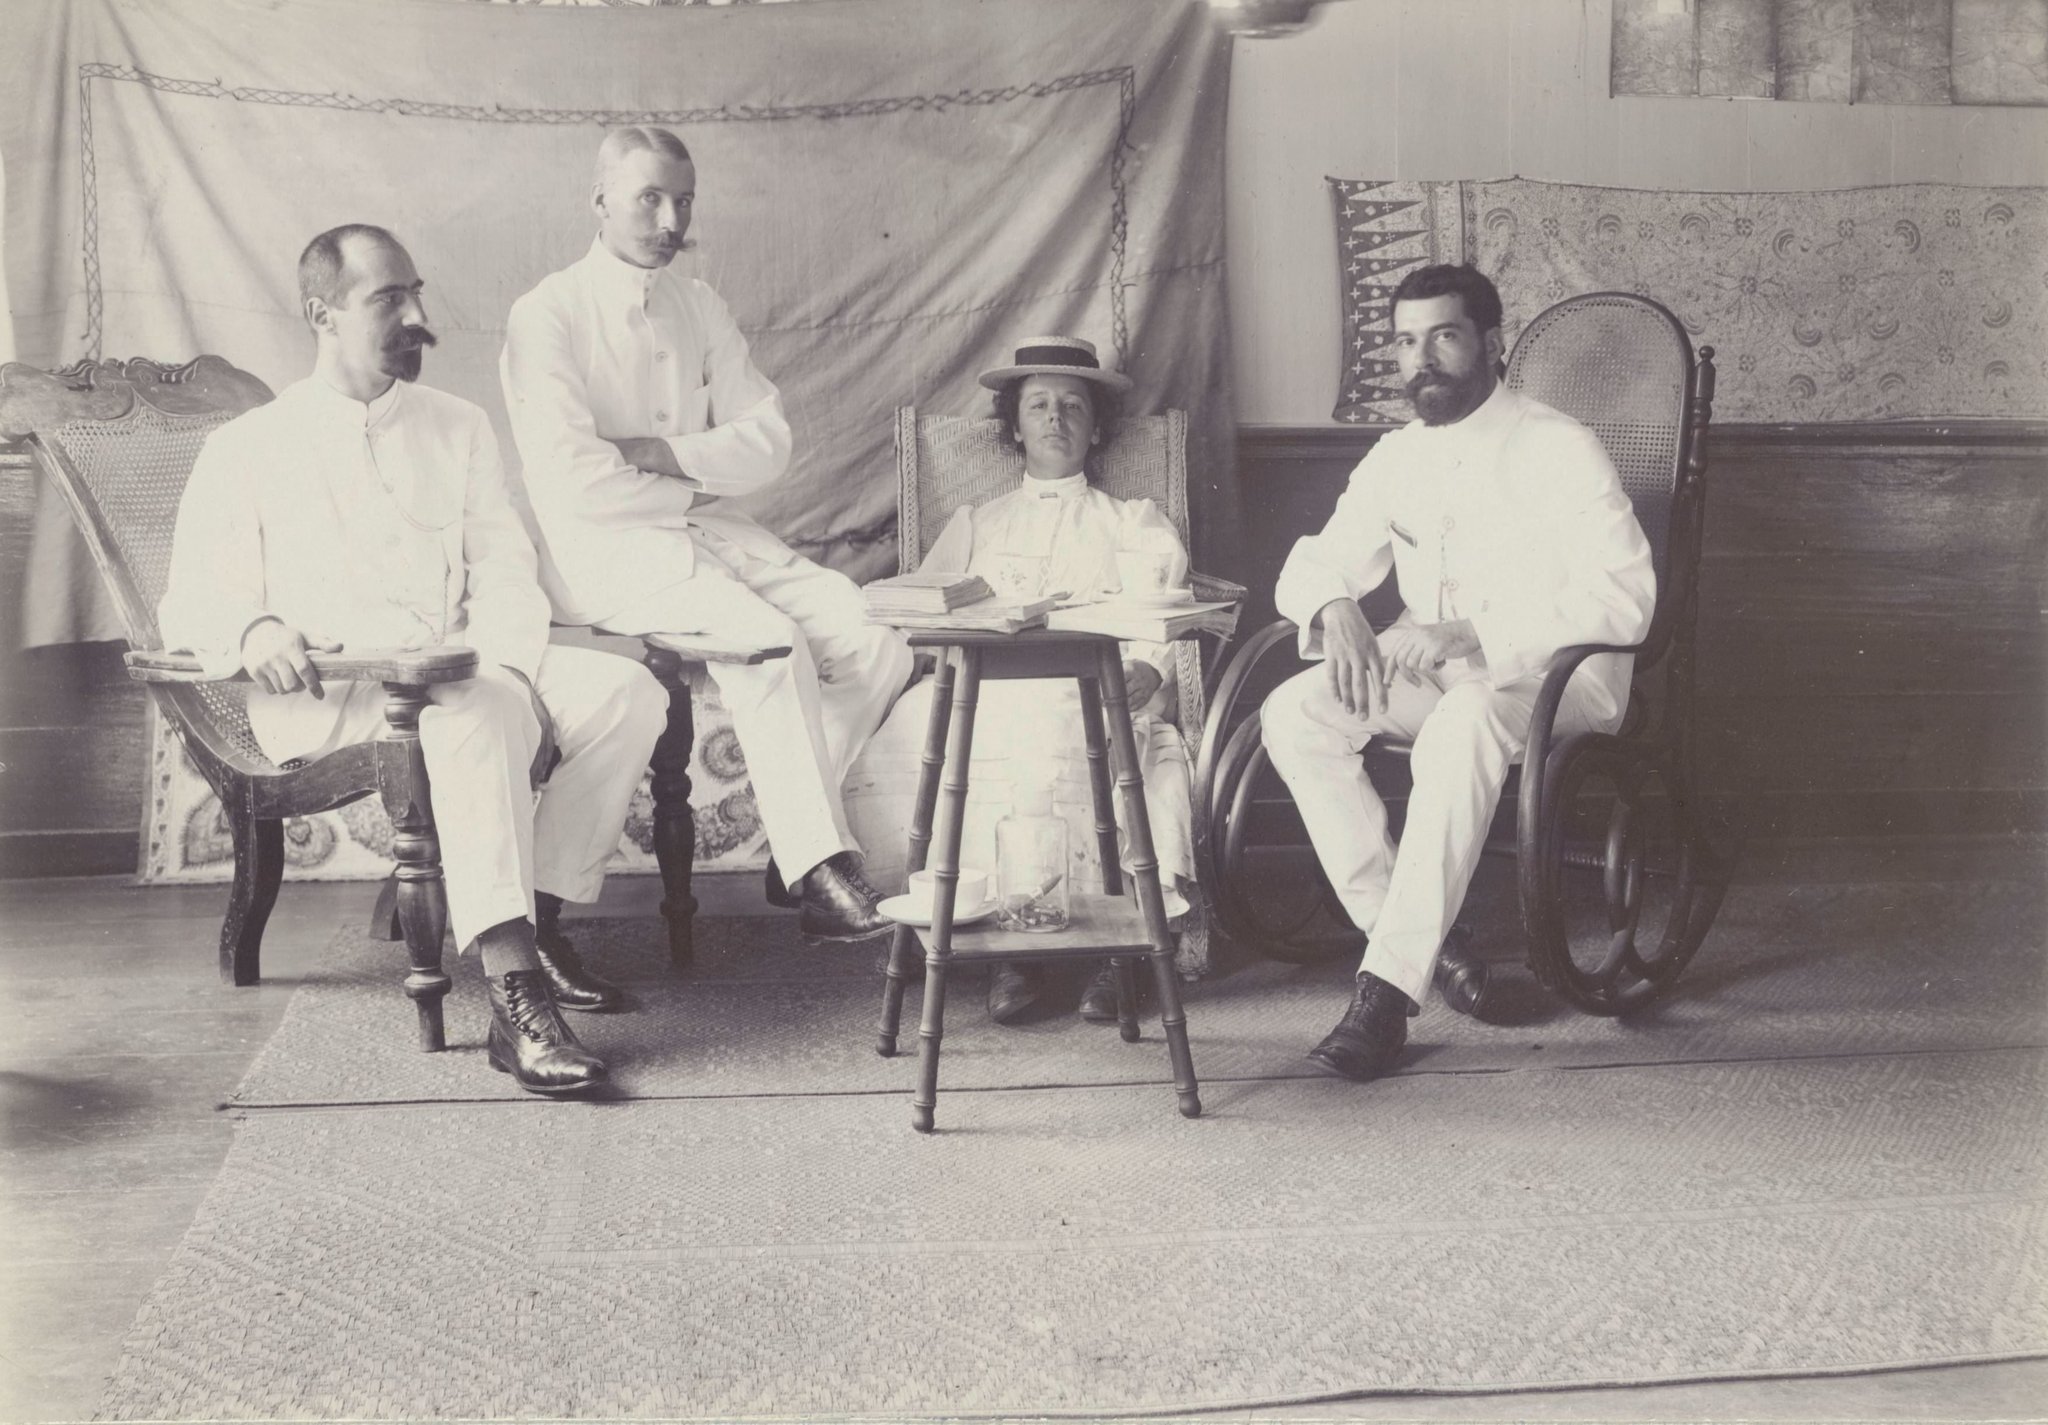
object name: photograph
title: Groepsfoto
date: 1908-1910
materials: photographic support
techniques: photography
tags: andries augustus boom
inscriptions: inscription: ‘Gravenstraat. Paramaribo. October 1908 / van der Werk - A.A. Boom - Freule de Jonge - Van Hall’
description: Groepsfoto in het huis van Dr. van Hall in de Gravenstraat: Dhr. van der Werk, Andries Boom, Freule de Jonge en Dr. van Hall. Paramaribo, oktober 1908. Onderdeel van het fotoalbum van de familie Boom-Gonggrijp in Suriname en Curaçao.